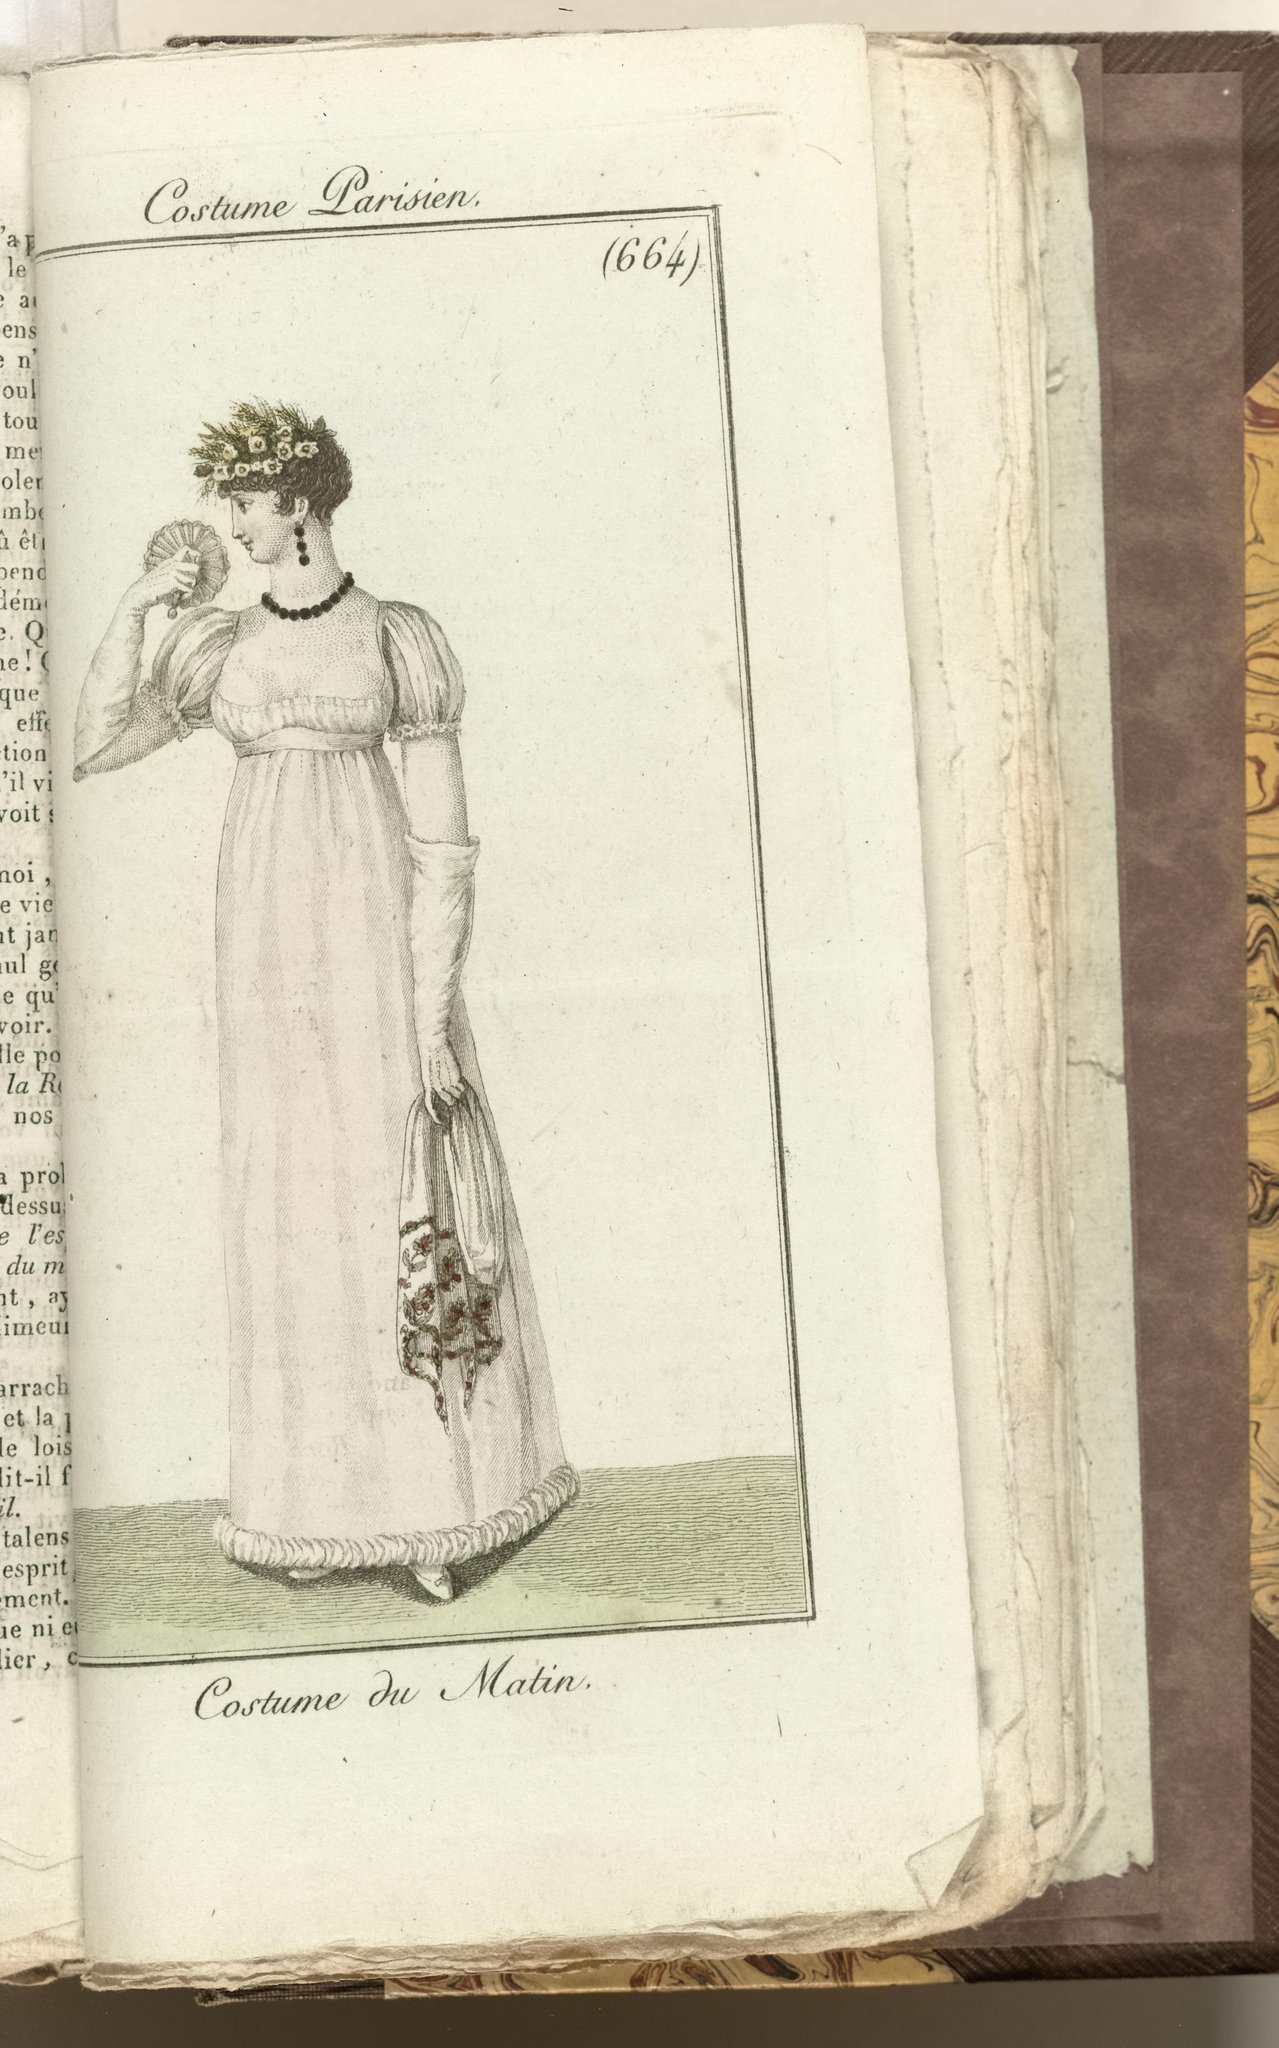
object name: fashion print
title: Journal des Dames et des Modes, Costume Parisien, 1805, An 13 (664) Costume du Matin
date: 1805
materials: paper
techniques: engraving, hand coloring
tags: ear-rings (+ women's clothes), gloves, mittens (long gloves) (+ women's clothes), dress, gown: morning dress (+ women's clothes), neck-gear ~ clothing (shawl) (+ women's clothes), fashion plates, fan (+ women's clothes), pearl; pearl necklace (+ women's clothes)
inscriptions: title: ‘Costume de Matin.’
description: Jonge vrouw in lichtroze ochtendjapon met laag decolleté en gestreepte pofmouwtjes. Lange witte handschoenen, halsketting en lange oorbellen. Het kapsel versierd met bloemen en korenaren. Een sjaal in de ene, kleine waaier in de andere hand. De prent maakt deel uit van het modetijdschrift Journal des Dames et des Modes, uitgegeven door Pierre de la Mésangère, Parijs, 1797-1839.